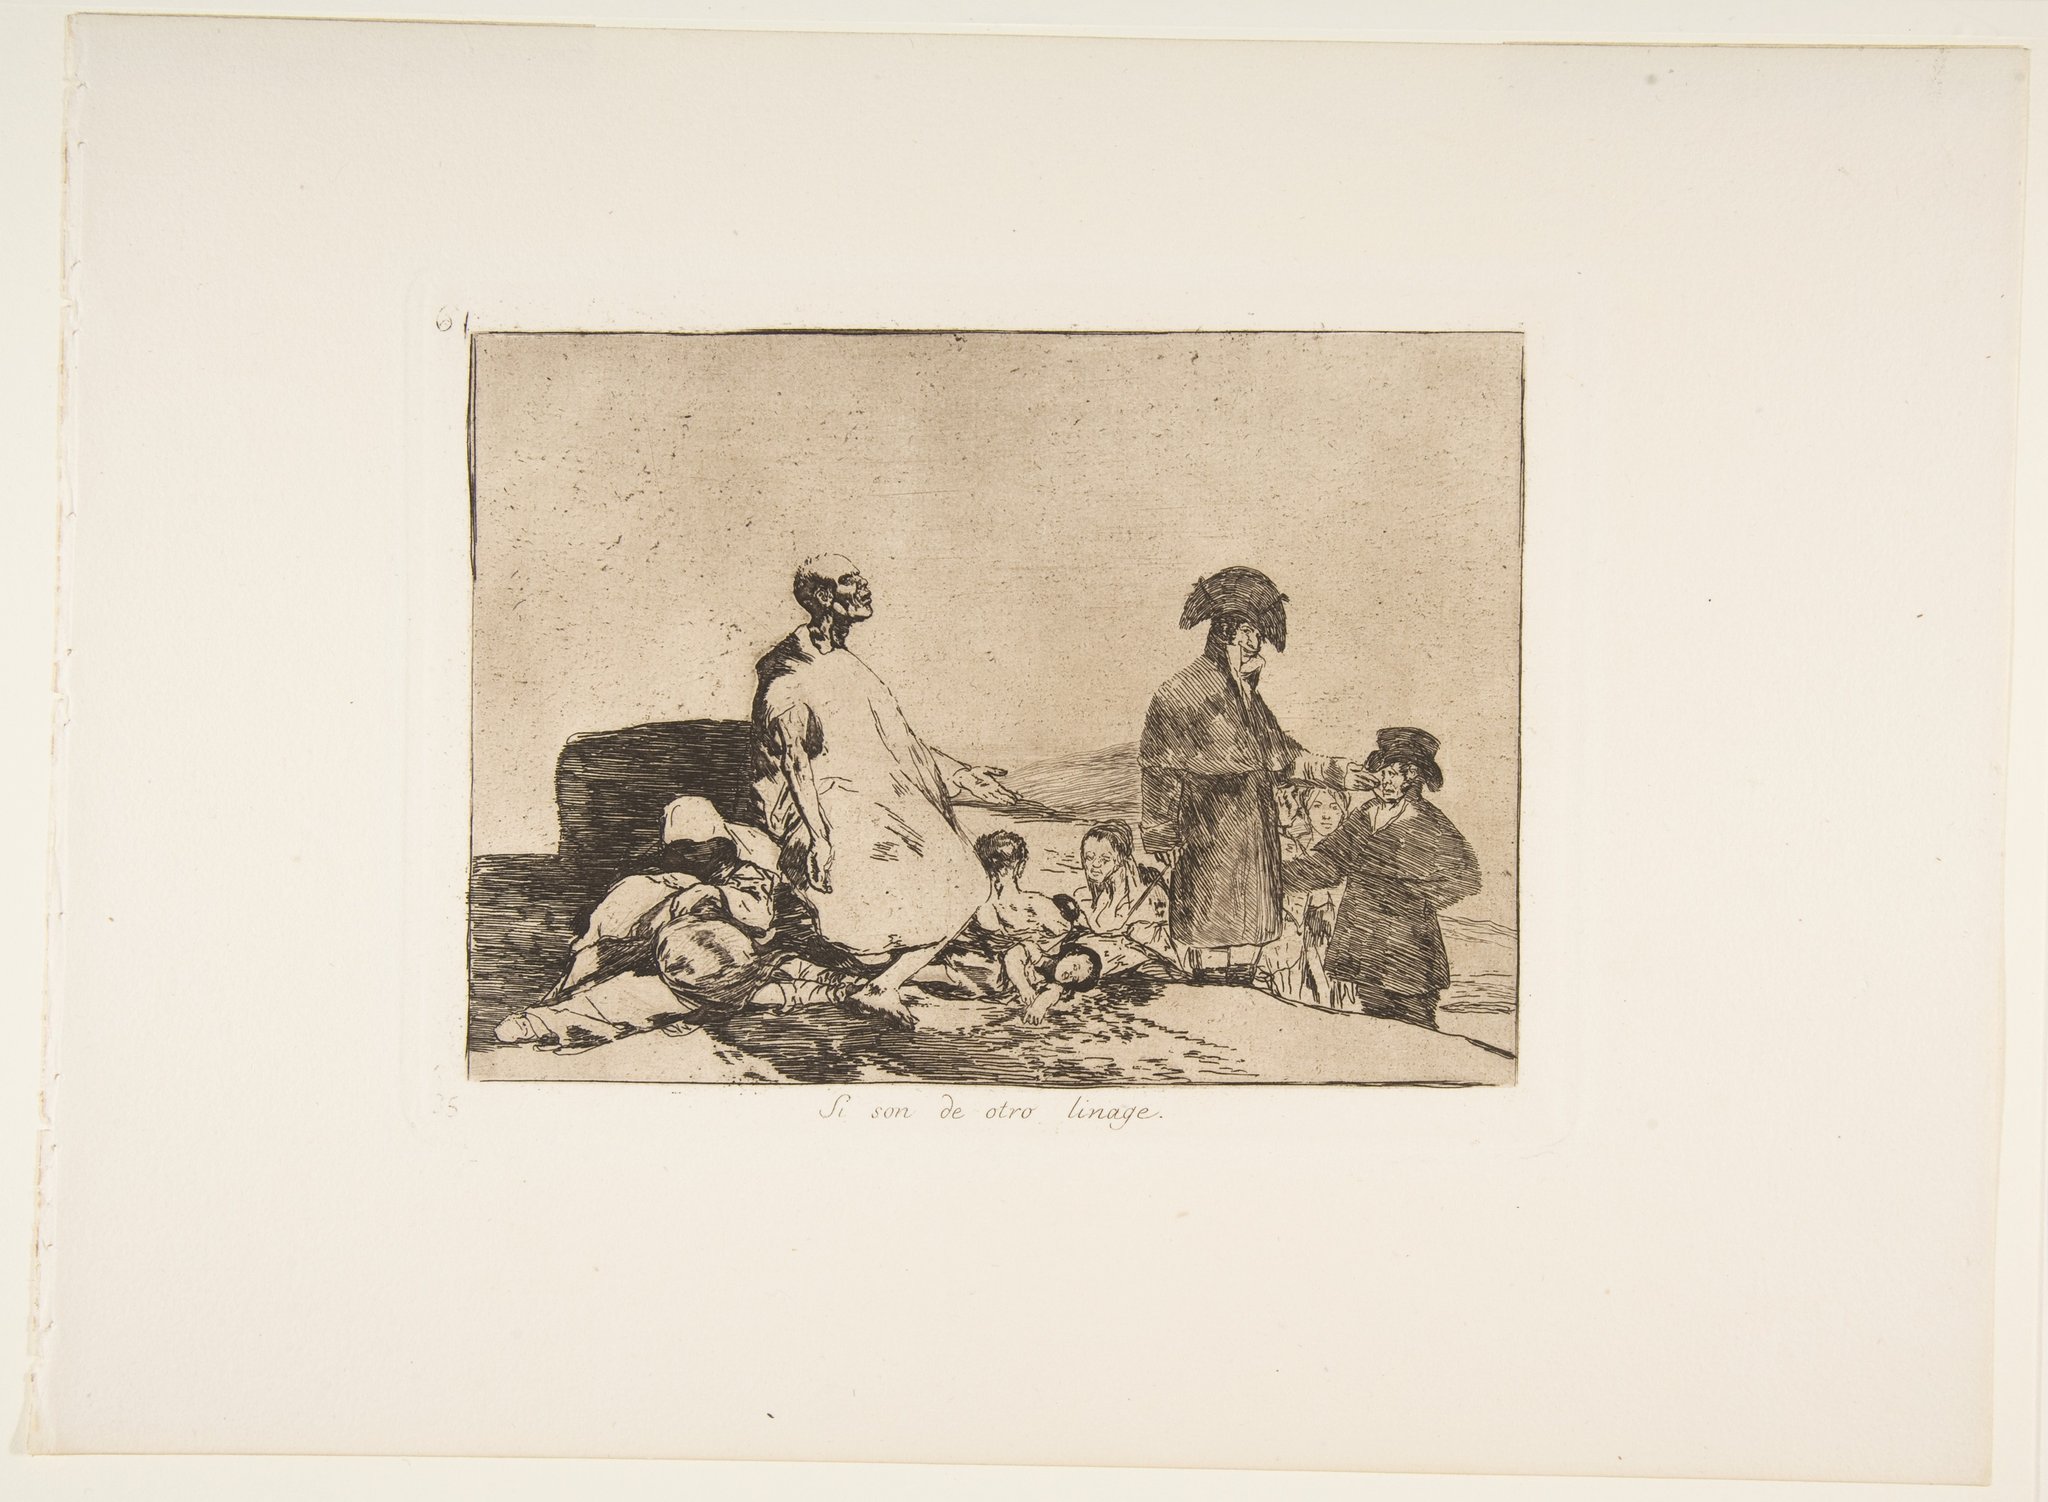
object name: print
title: Plate 61 from "The Disasters of War" (Los Desastres de la Guerra): 'Perhaps they are of another breed' (Si son de otro linage)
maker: goya (francisco de goya y lucientes)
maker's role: artist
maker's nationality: spanish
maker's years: 1746-1828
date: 1811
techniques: engraving, drypoint, etching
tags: men